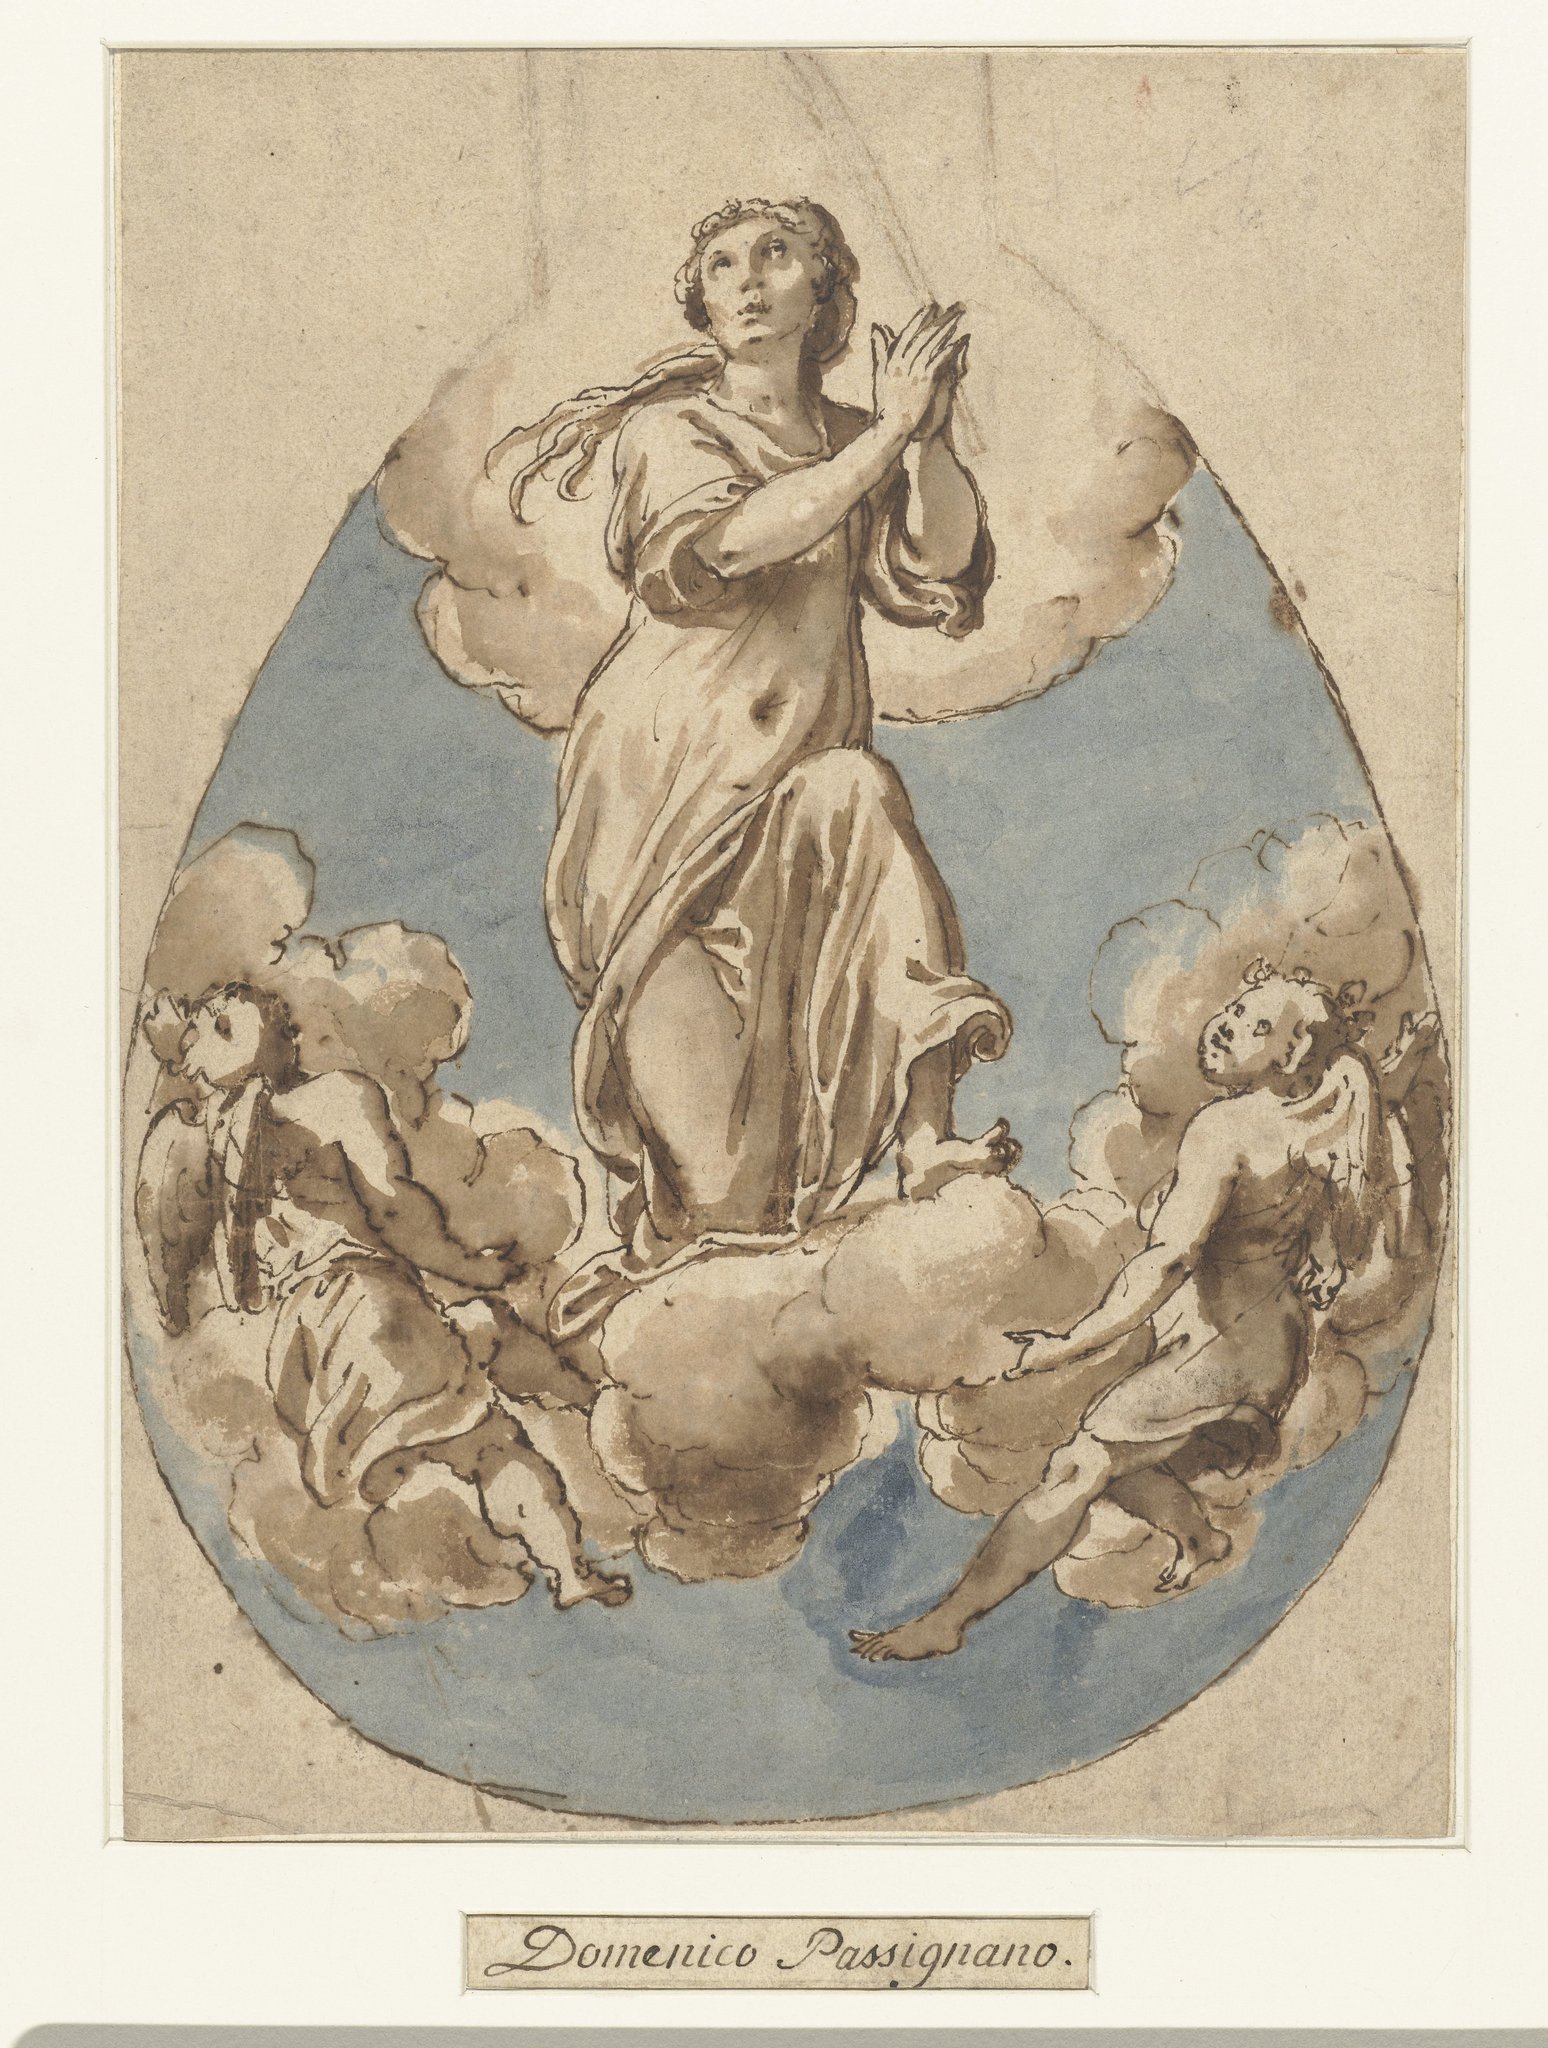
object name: drawing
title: Ten Hemelopneming van Maria of van een vrouwelijke martelares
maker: cesare nebbia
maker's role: draughtsman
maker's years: 1536-1614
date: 1546-1614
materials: paper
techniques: brush, pen